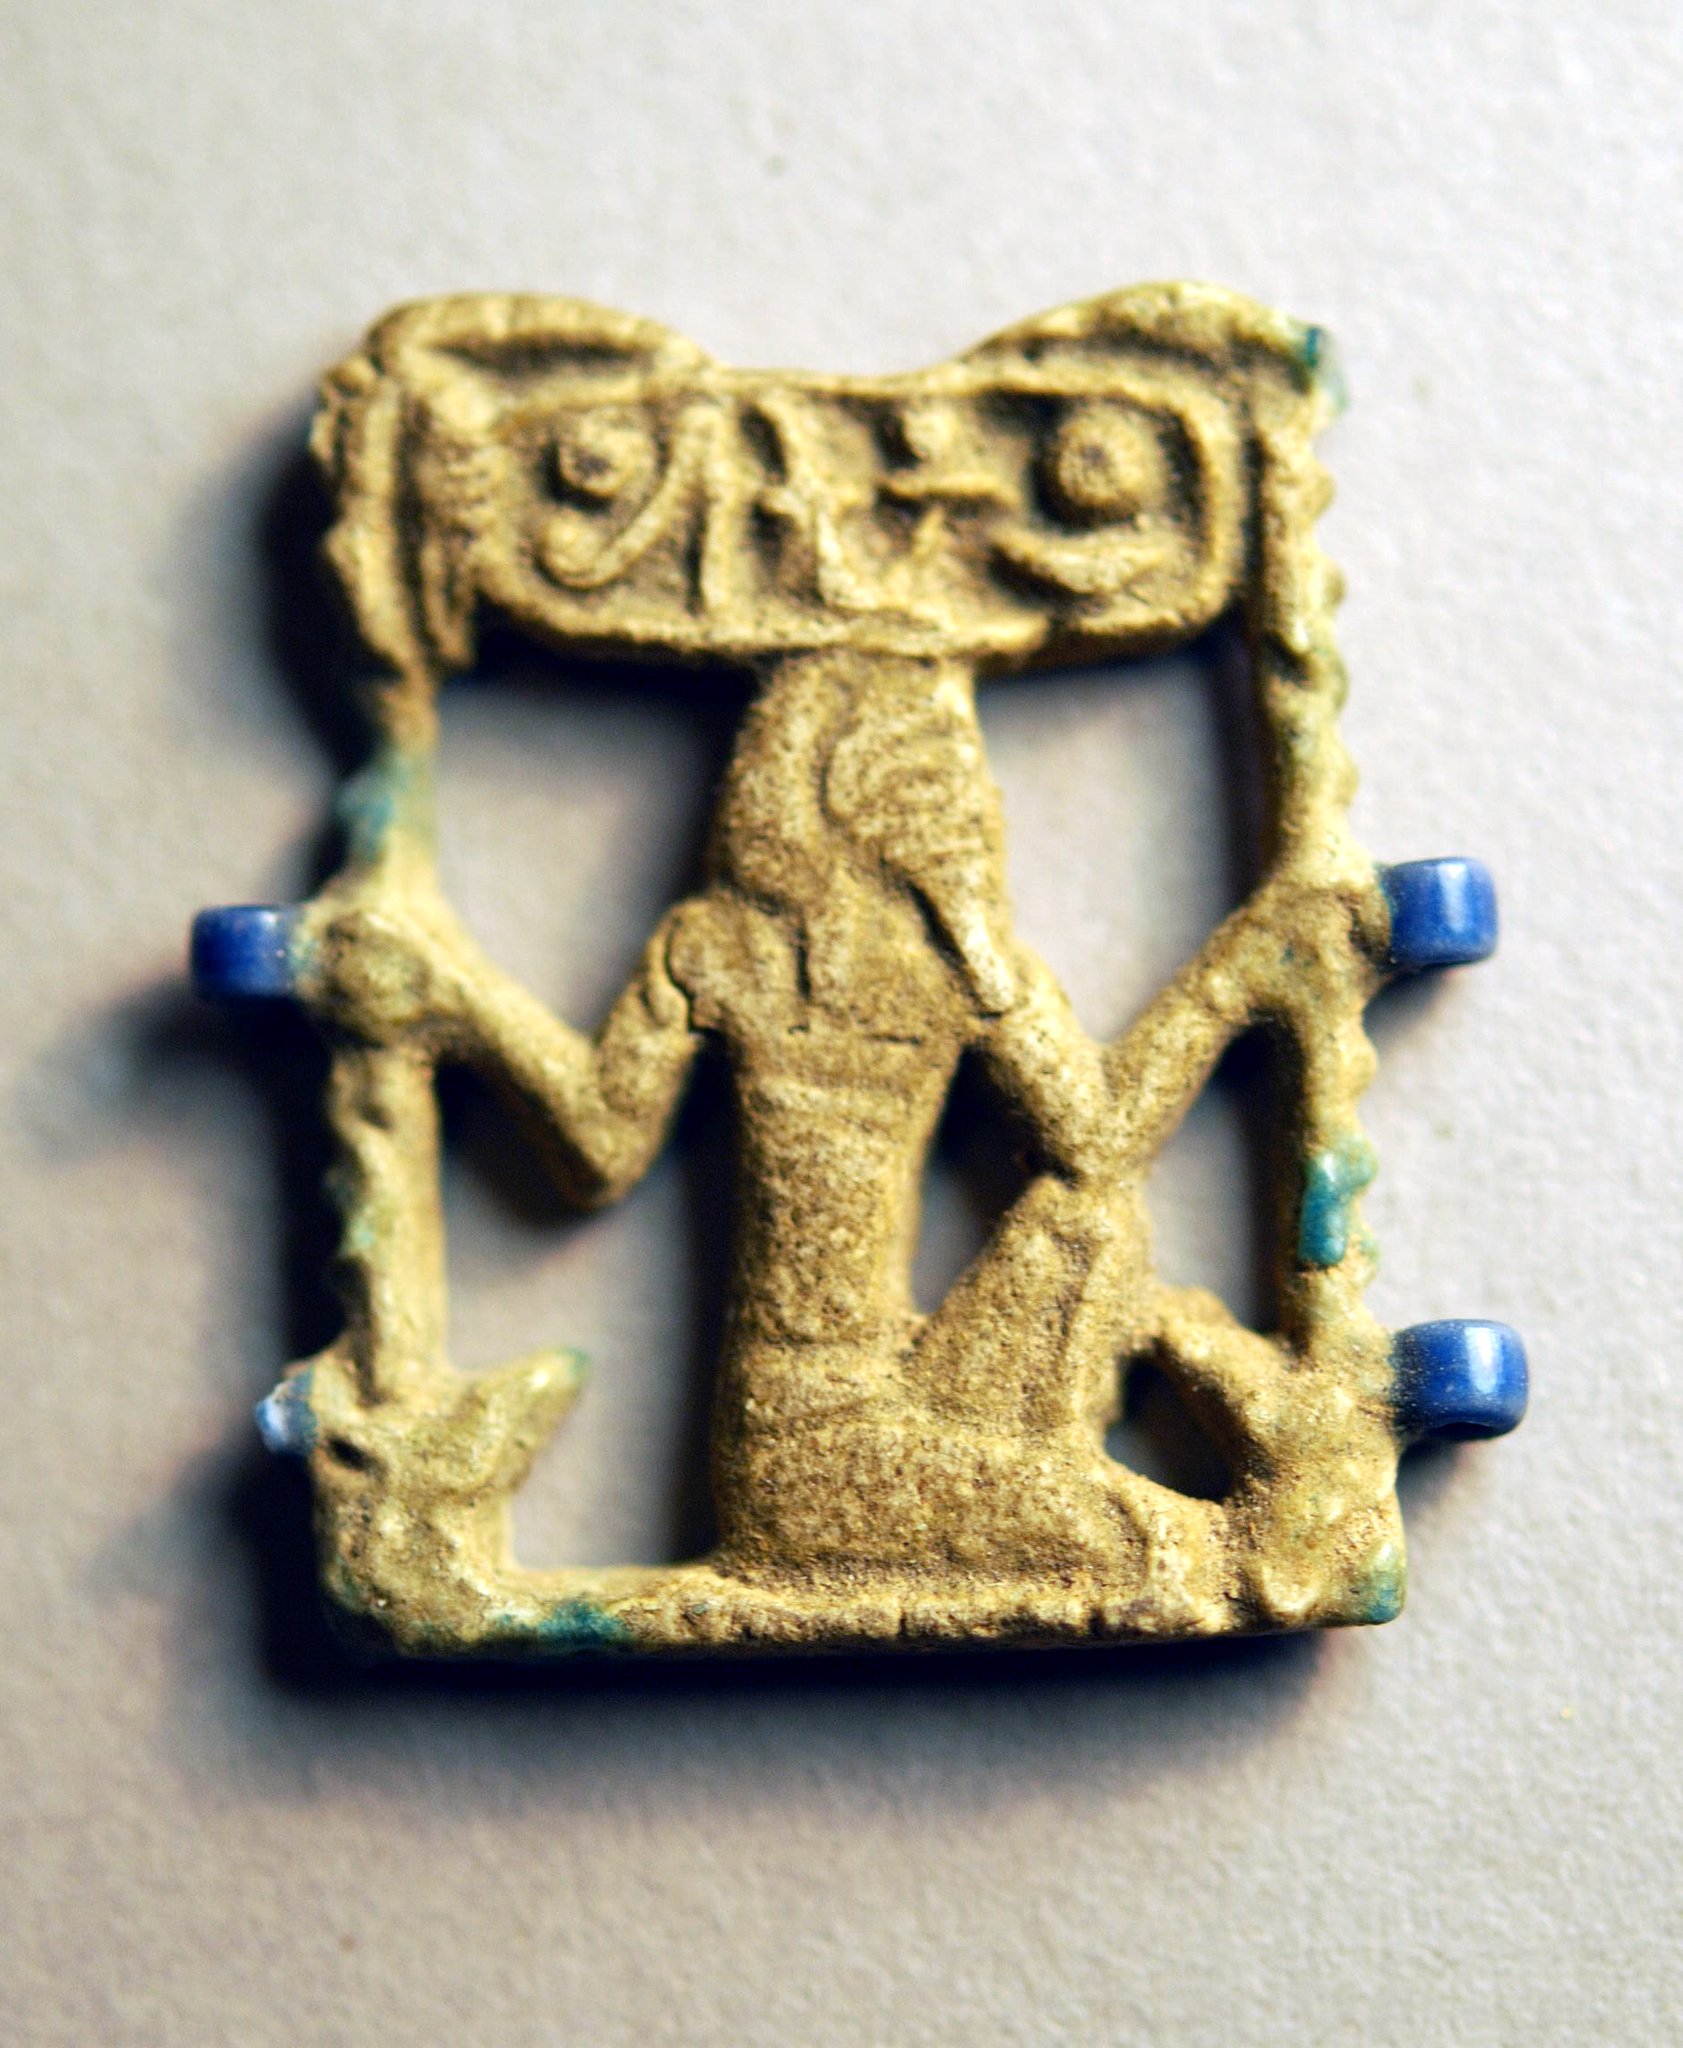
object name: amulet, heh hieroglyph, amenhotep iii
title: Heh amulet with the Name of Amenhotep III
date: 1390-1352 BCE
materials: faience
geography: egypt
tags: hieroglyphs